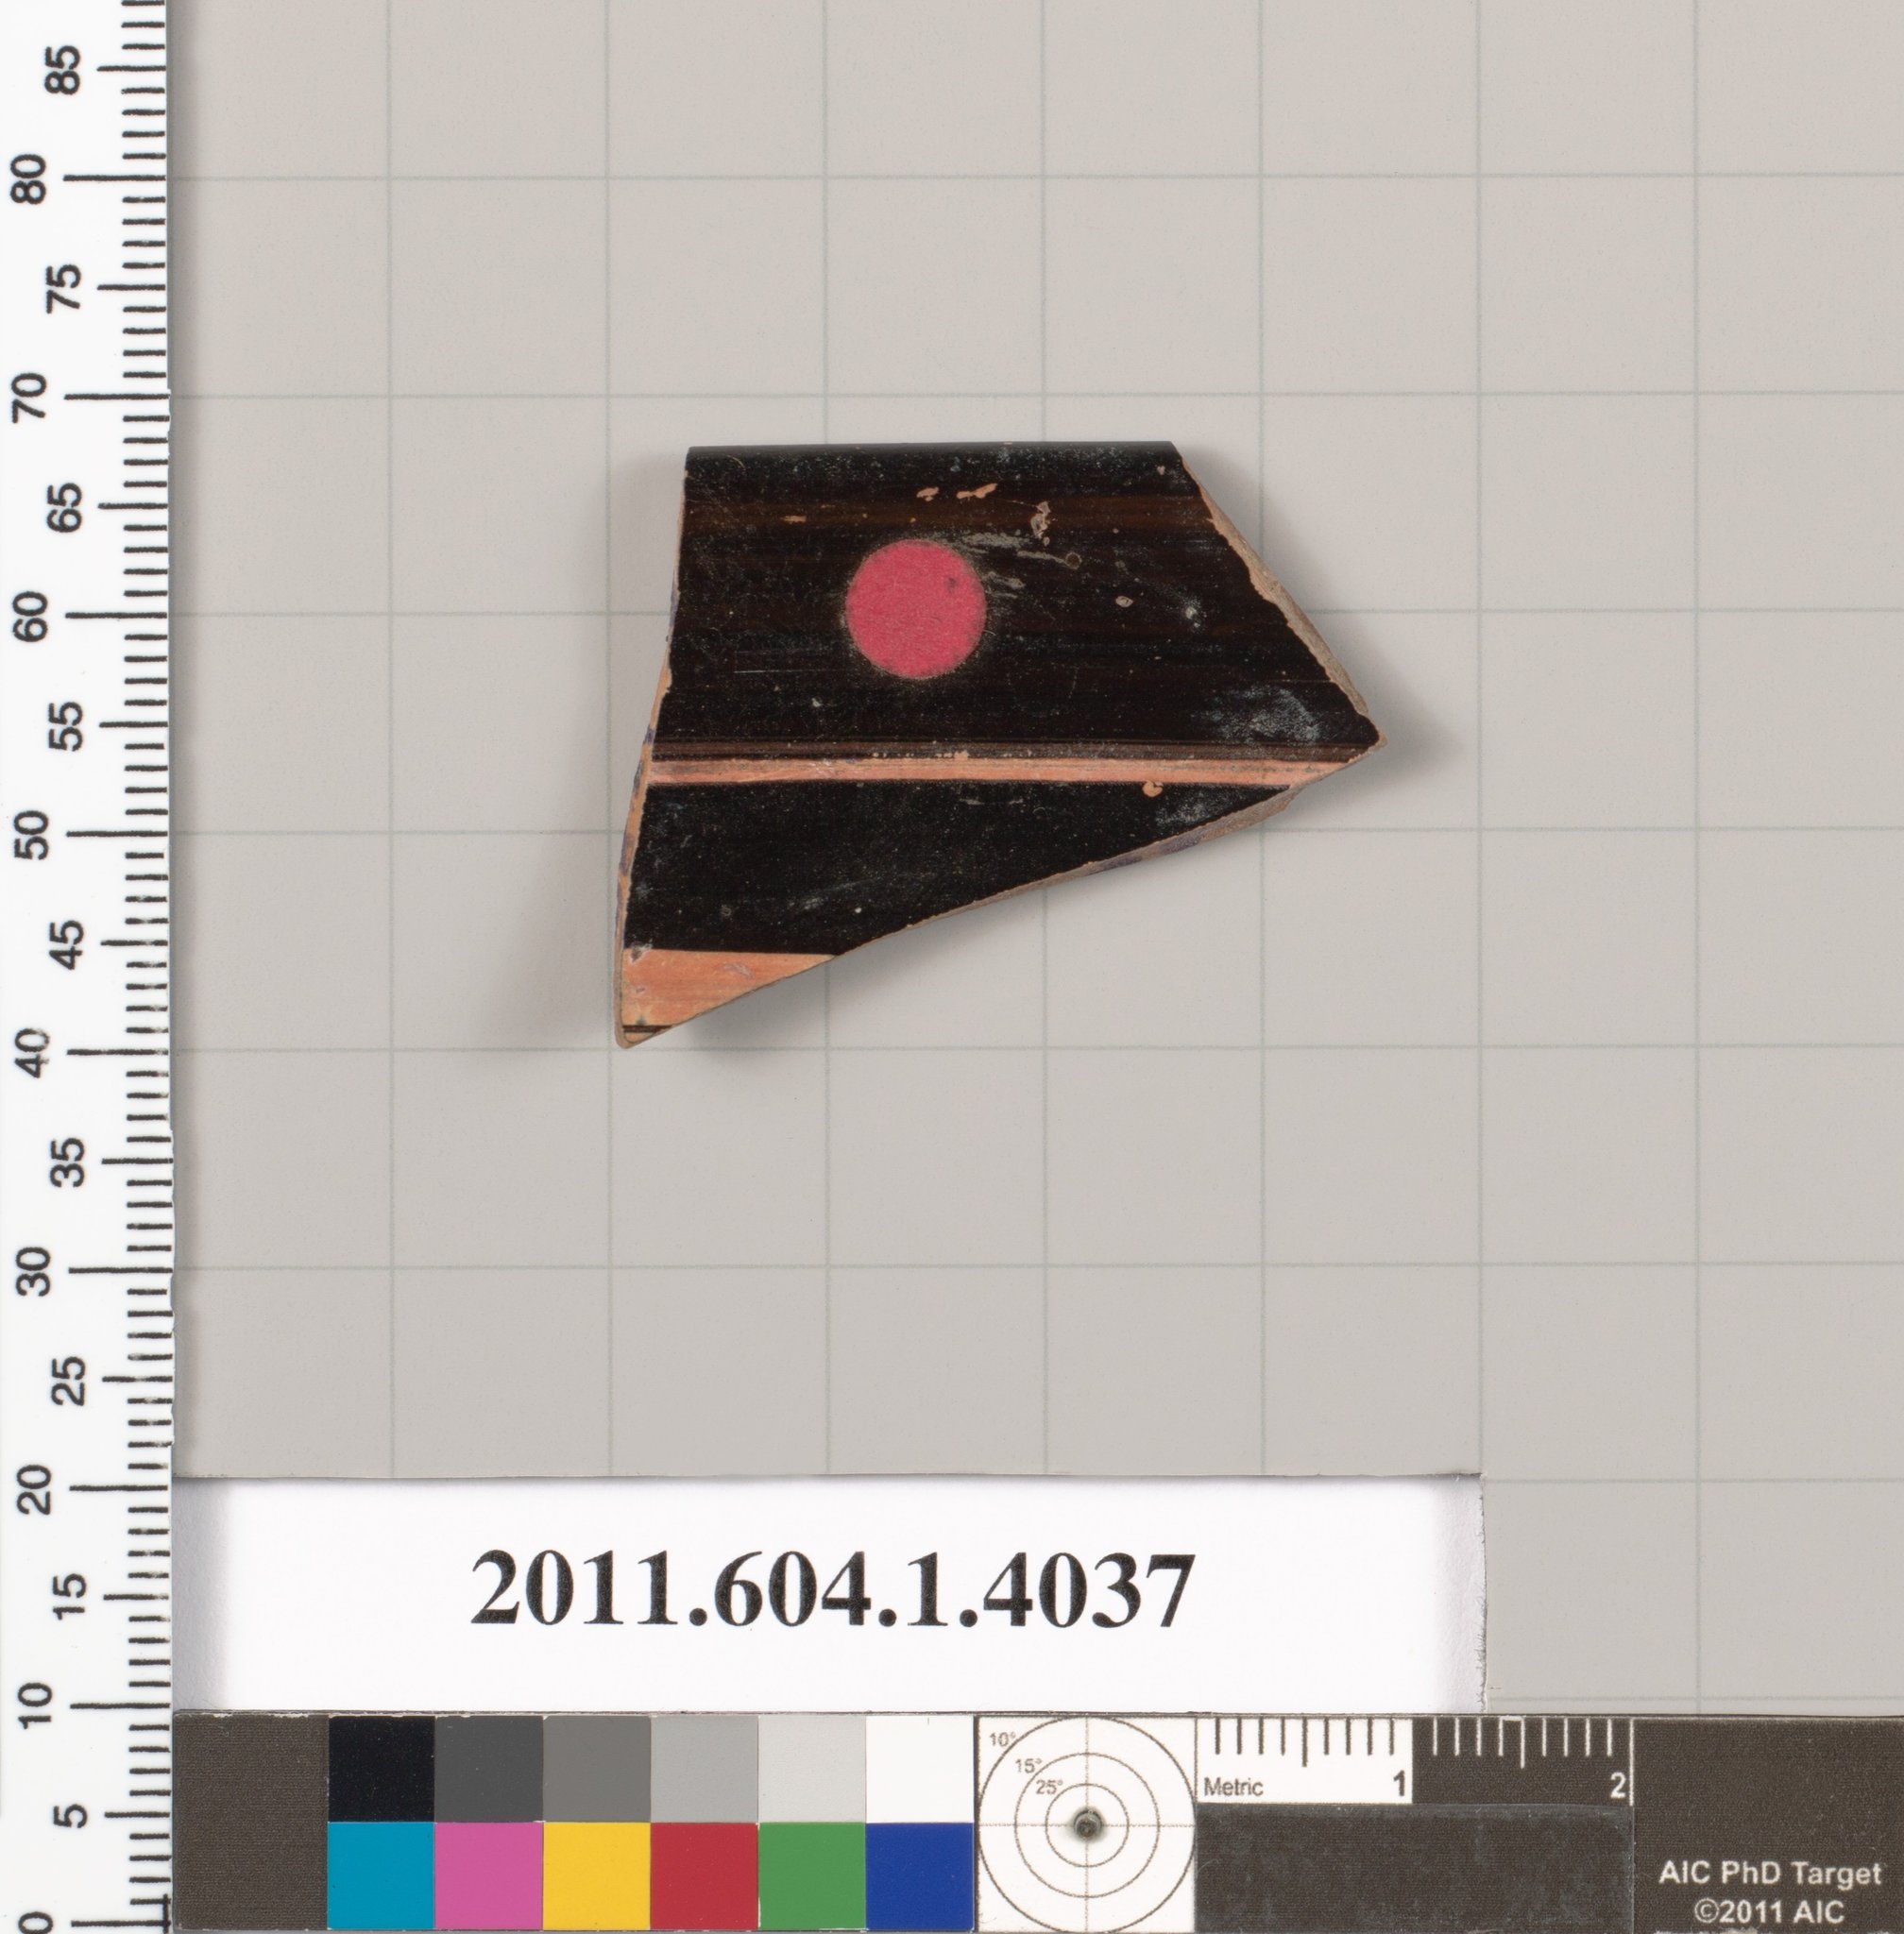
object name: kylix fragment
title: Terracotta fragment of a kylix (drinking cup)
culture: greek, attic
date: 460-440 BCE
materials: terracotta